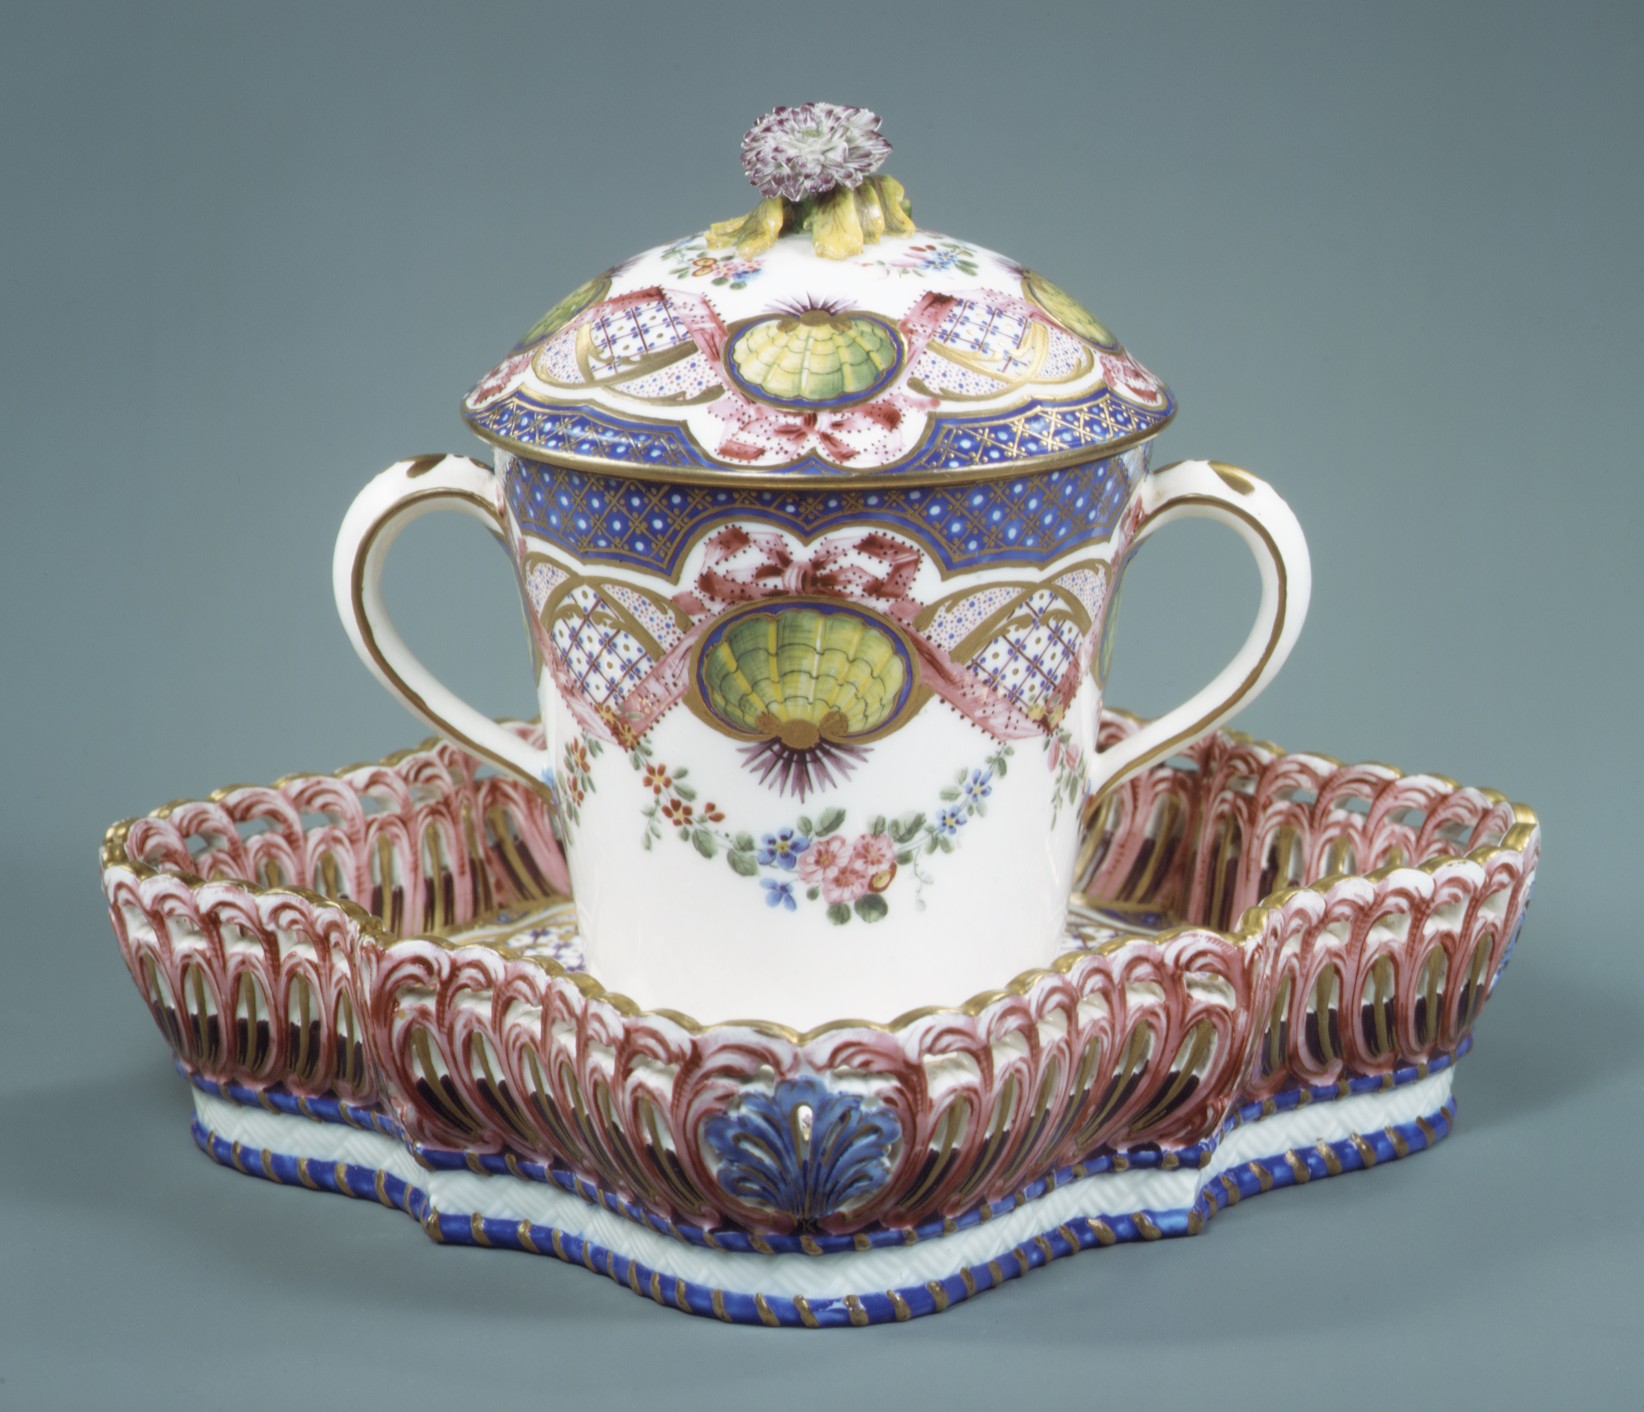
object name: cup with cover and tray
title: Cup with cover and tray (gobelet à lait et corbeille carré)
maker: sèvres manufactory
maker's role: manufactory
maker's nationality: french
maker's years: 1740-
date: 1764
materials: soft paste porcelain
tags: flowers